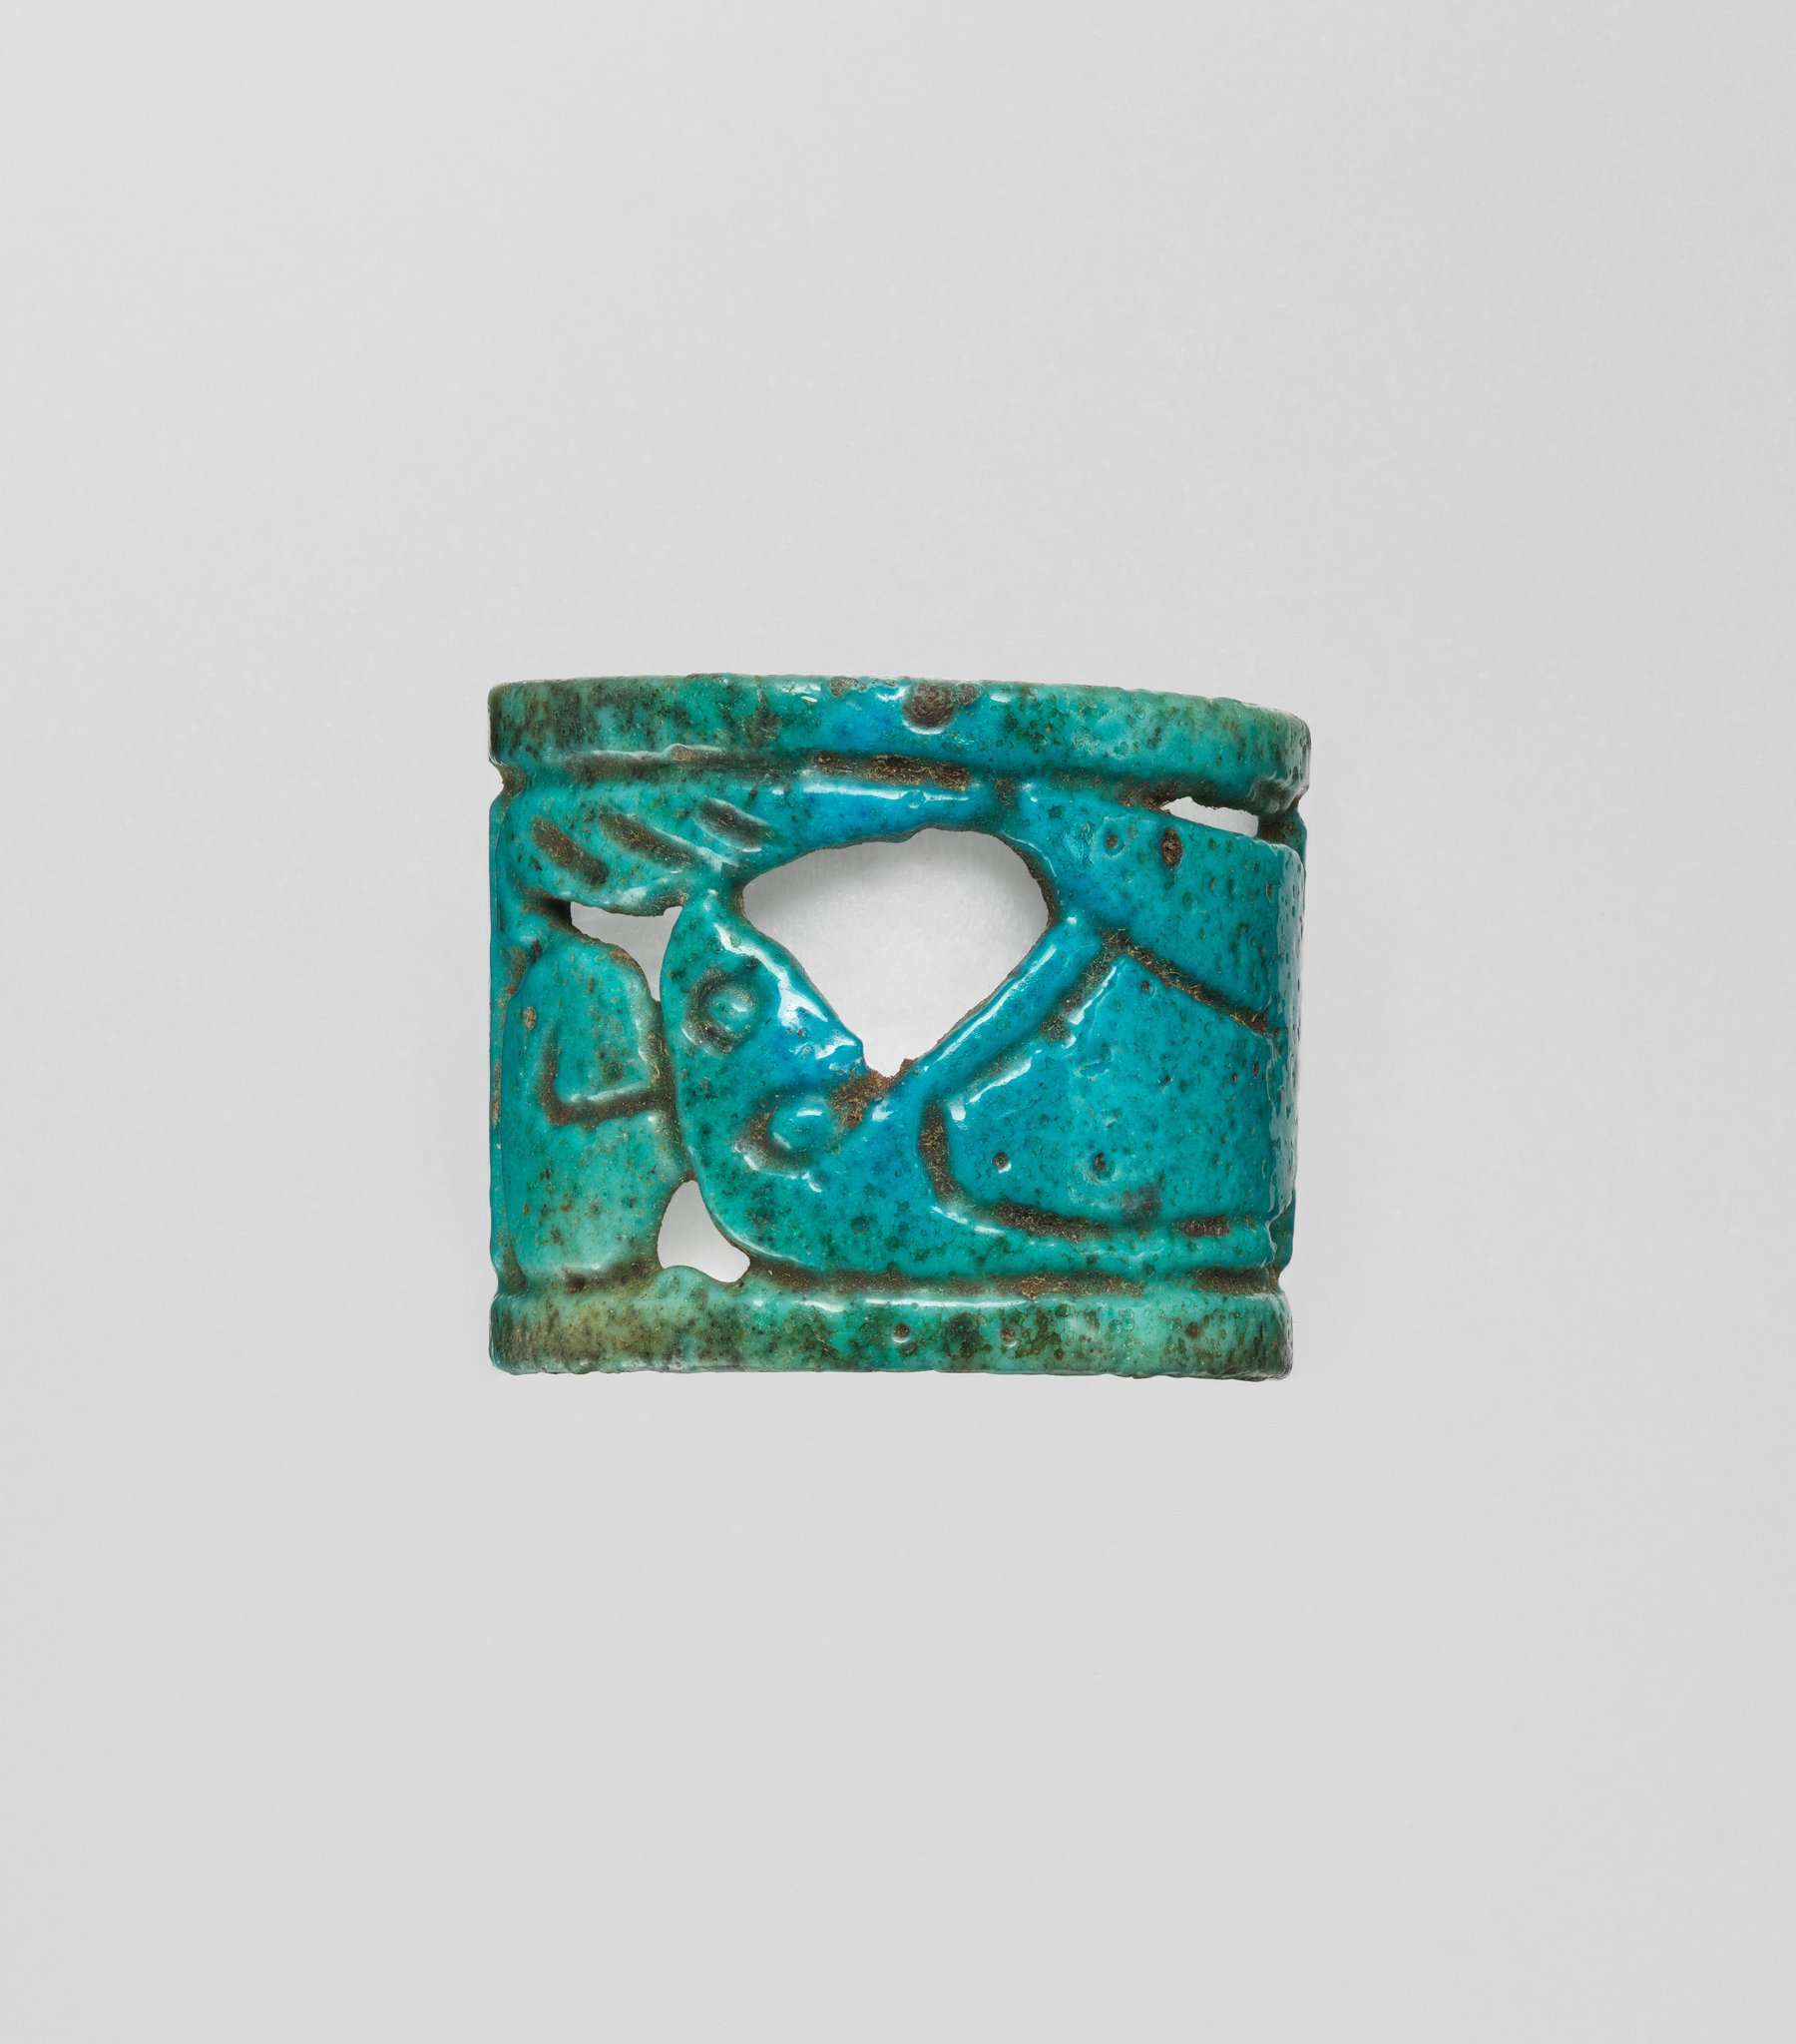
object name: ring, openwork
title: Openwork Ring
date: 1070-712 BCE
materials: faience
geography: egypt